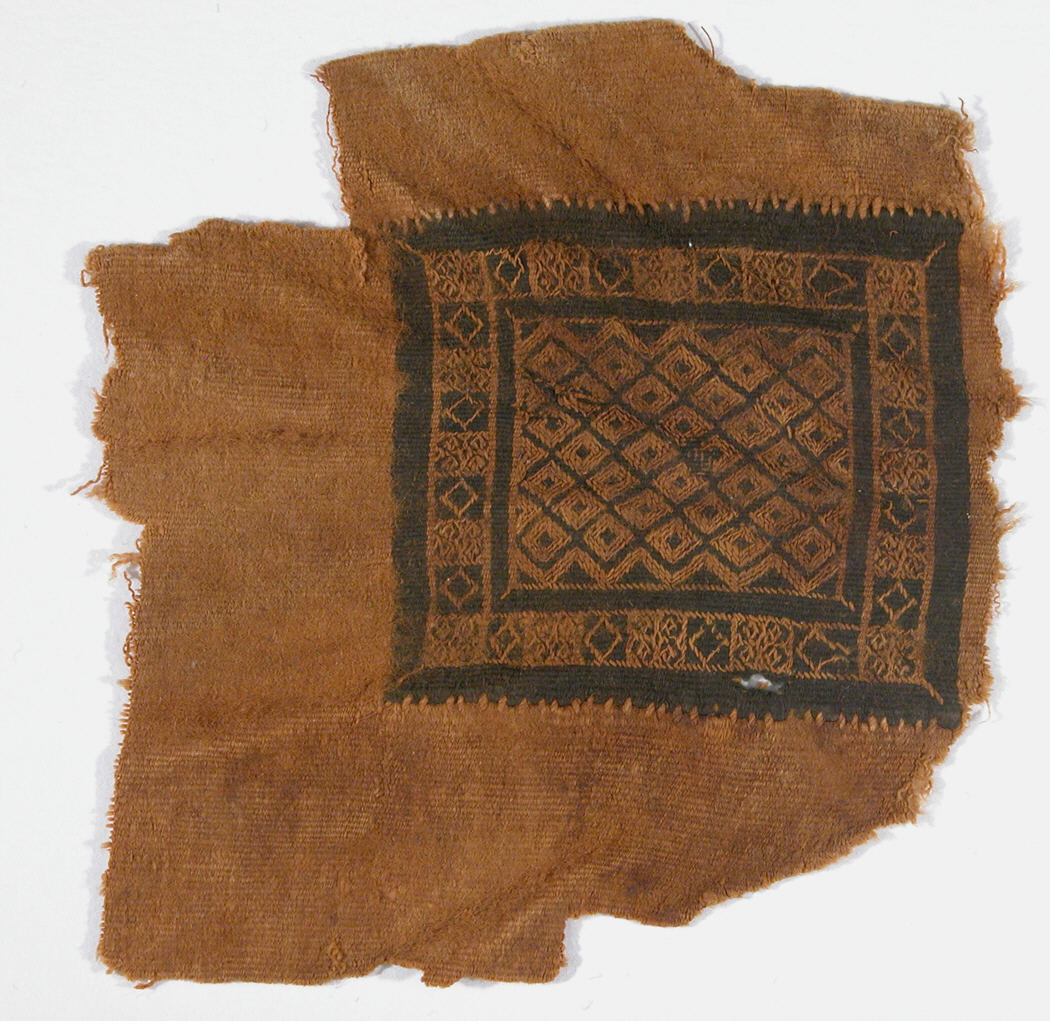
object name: panel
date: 301-500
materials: wool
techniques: tapestry, weave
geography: egypt